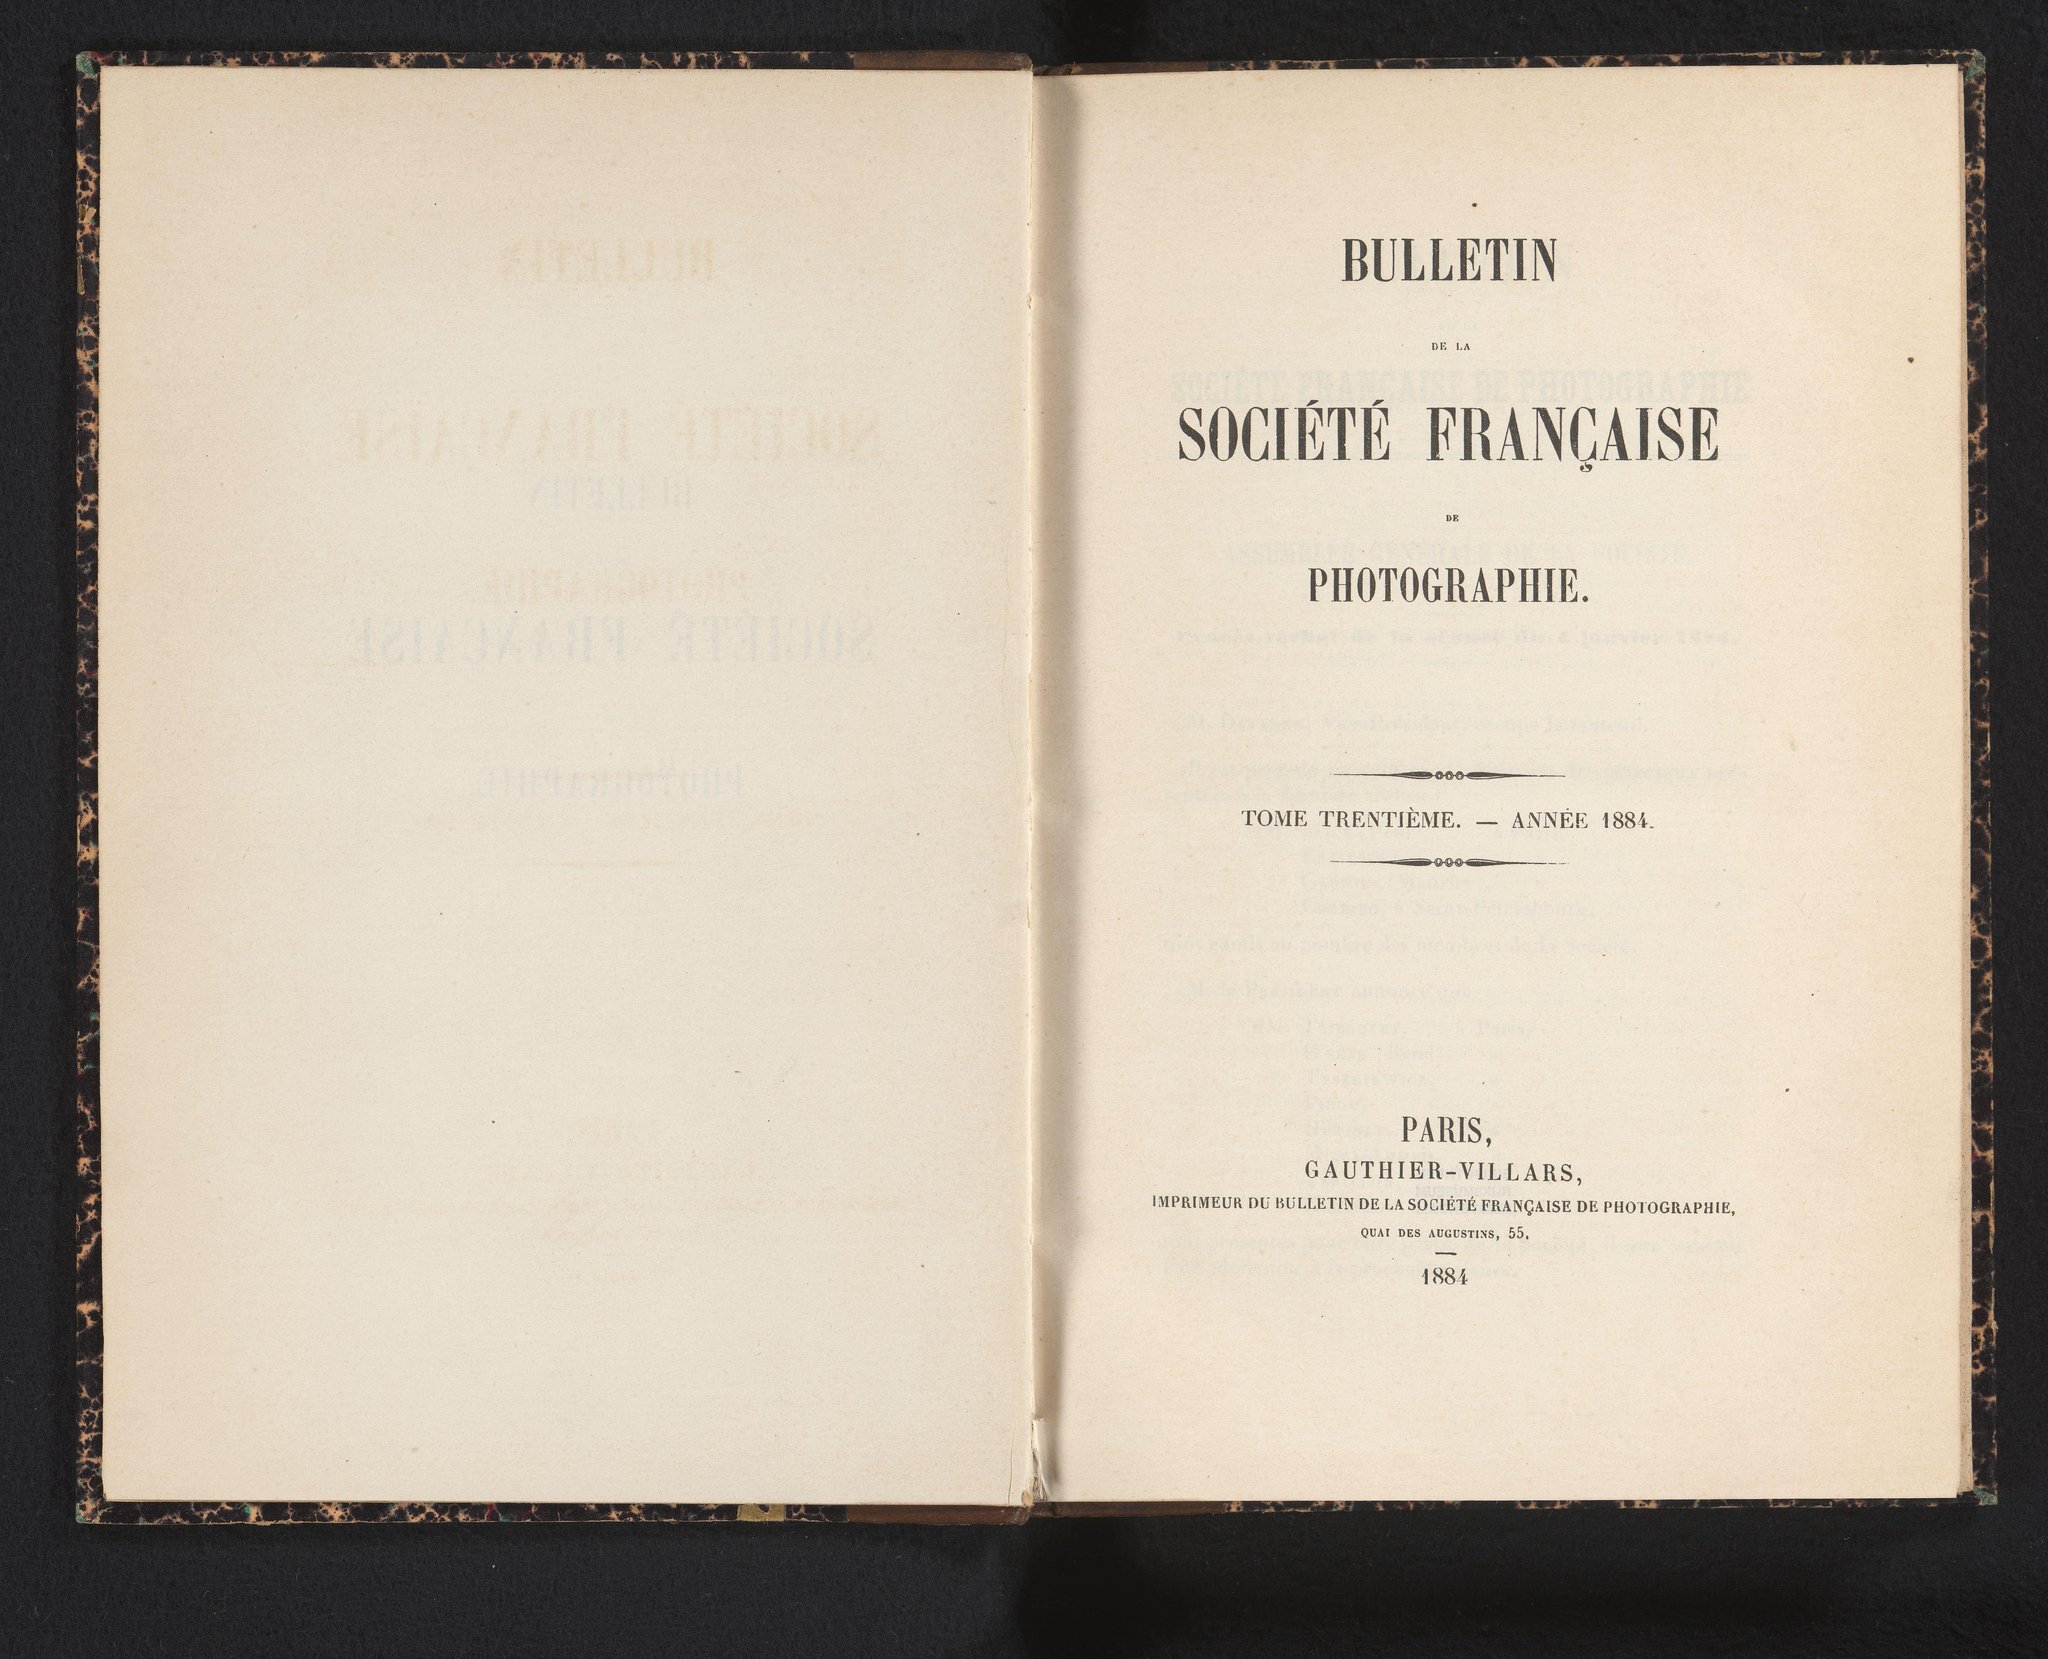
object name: book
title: Bulletin de la Société française de photographie. Tome trentième - année 1884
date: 1884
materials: paper, cardboard, leather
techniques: photograph, letterpress printing, marbling, marbled paper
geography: paris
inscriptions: number: ‘30’